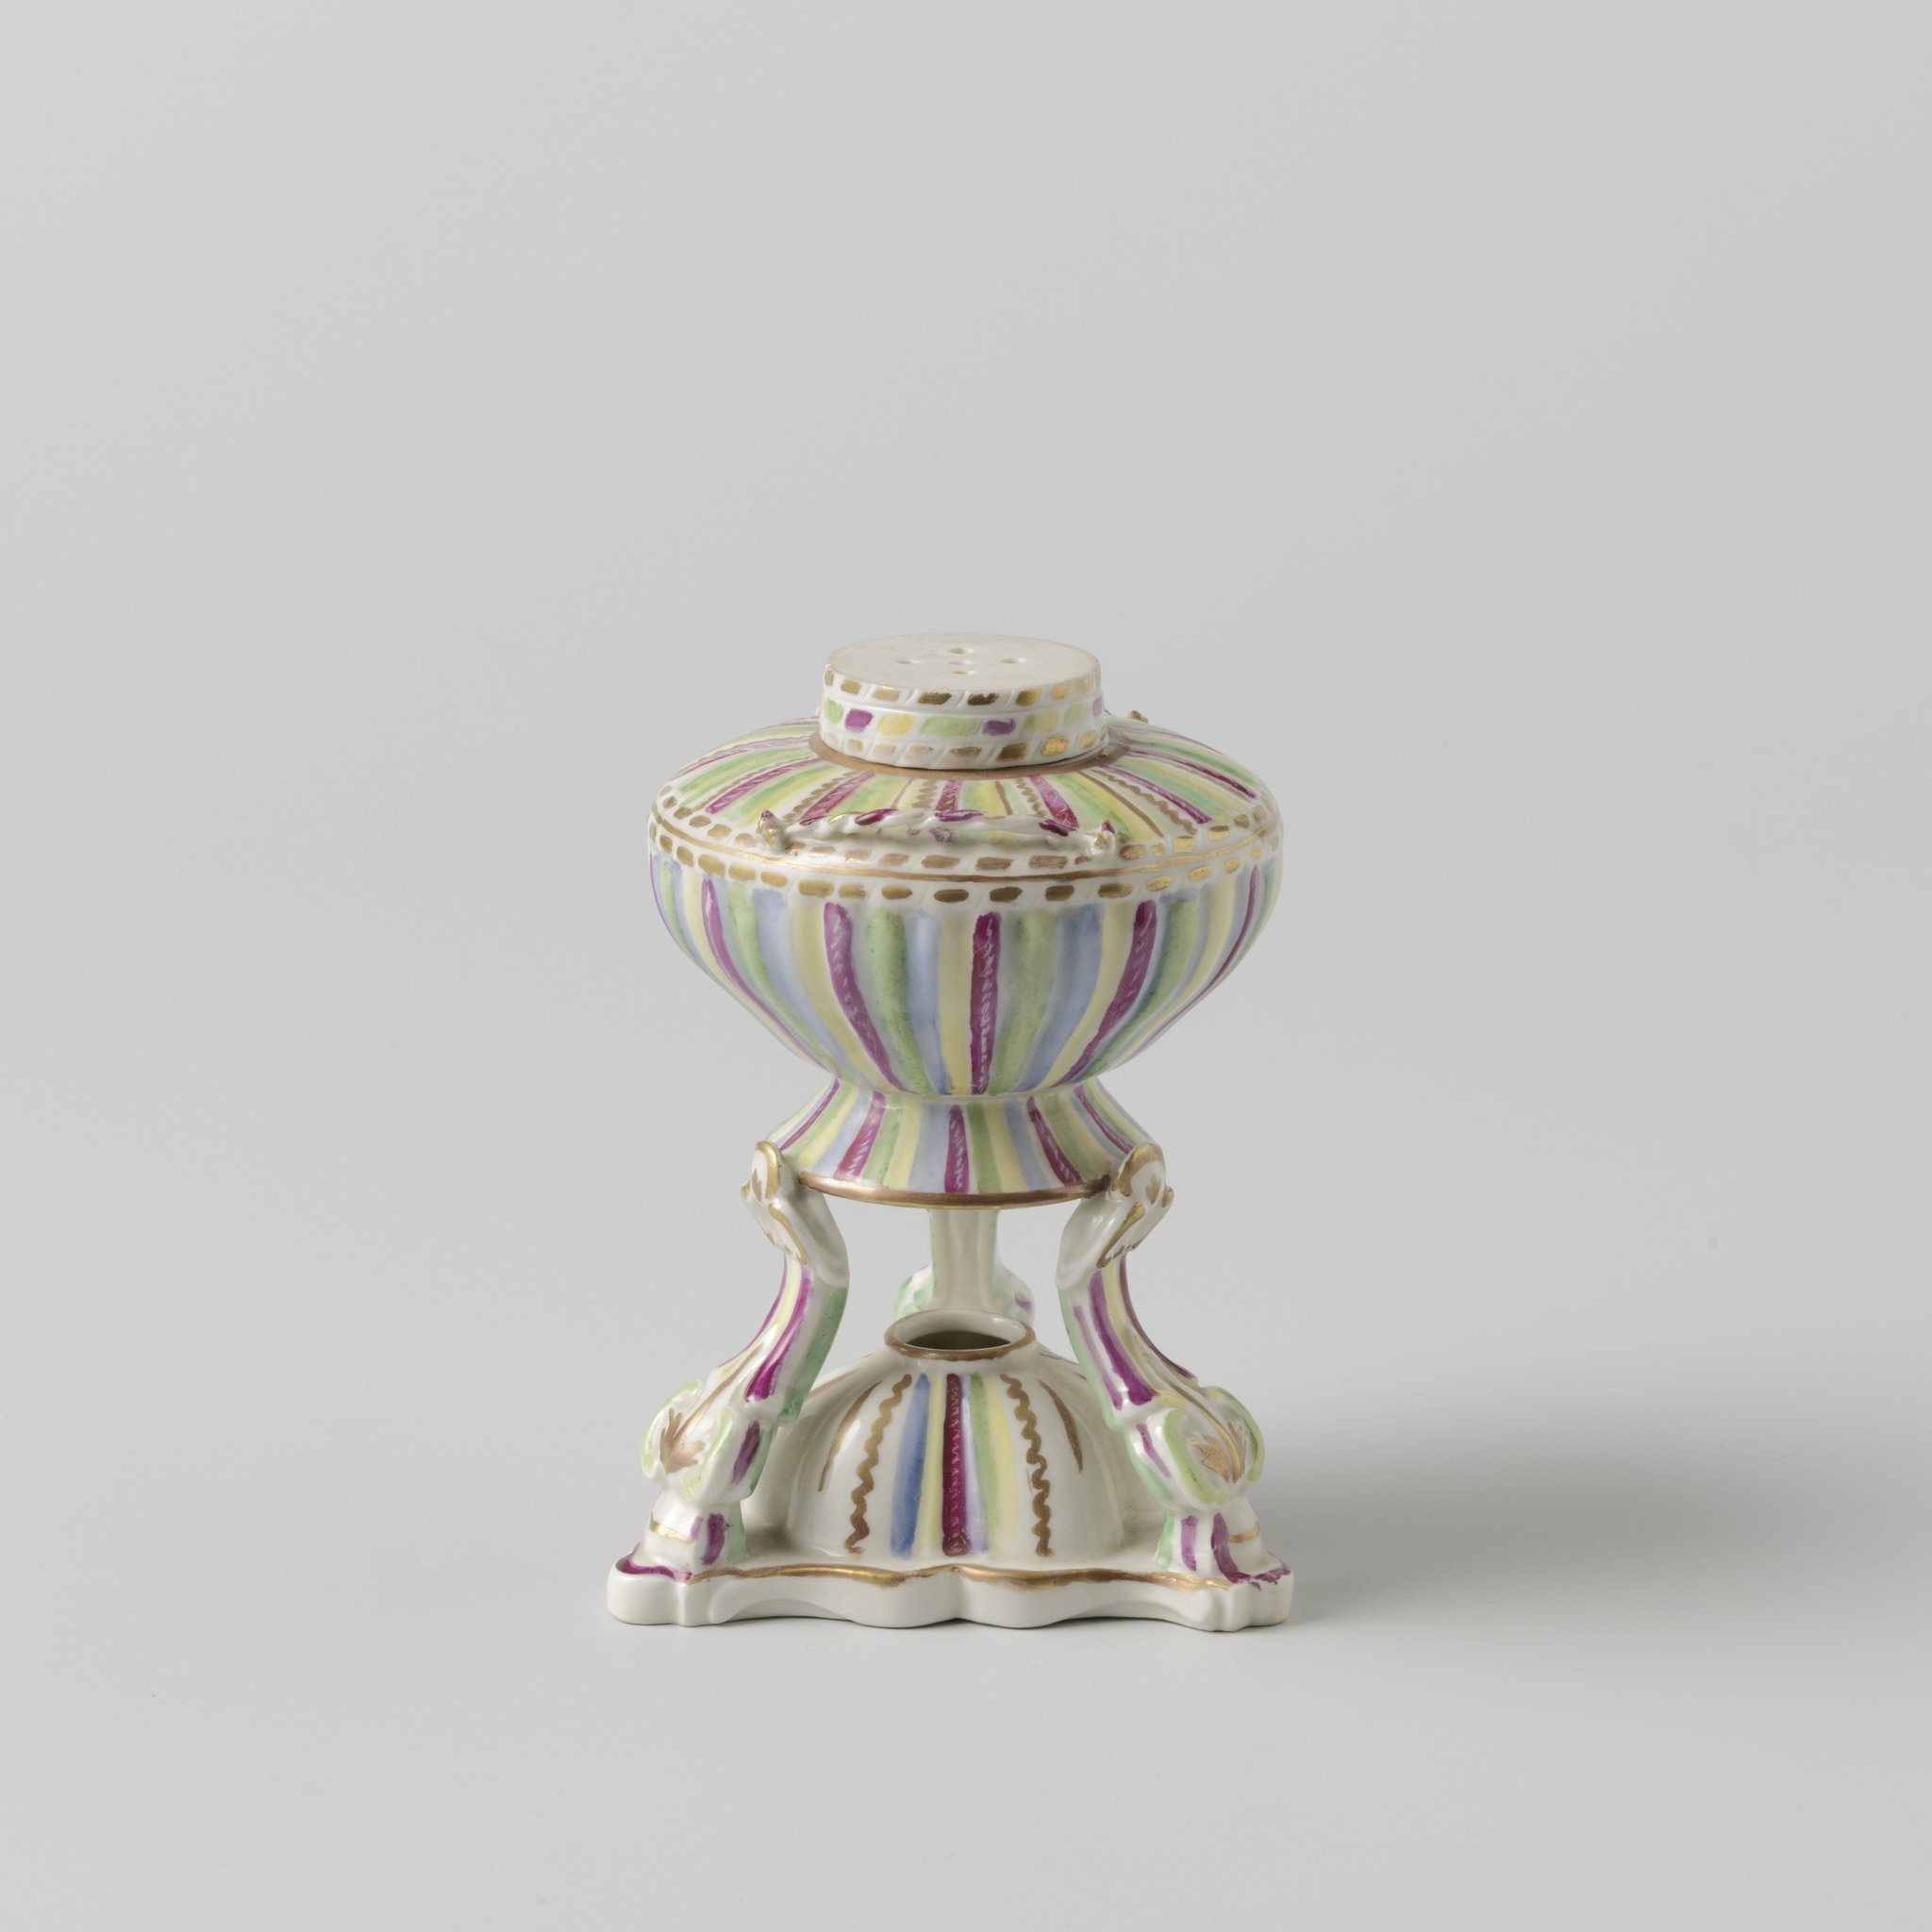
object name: incense burner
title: Wierookbrander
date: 1777-1790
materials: porcelain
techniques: painted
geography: the hague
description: Wierookbrander zonder deksel, bestaande uit een geribd potje op drie poten versierd met rocaille voluten en bladeren in relief. Het potje is versierd met veelkleurige strepen. Niet gemerkt.